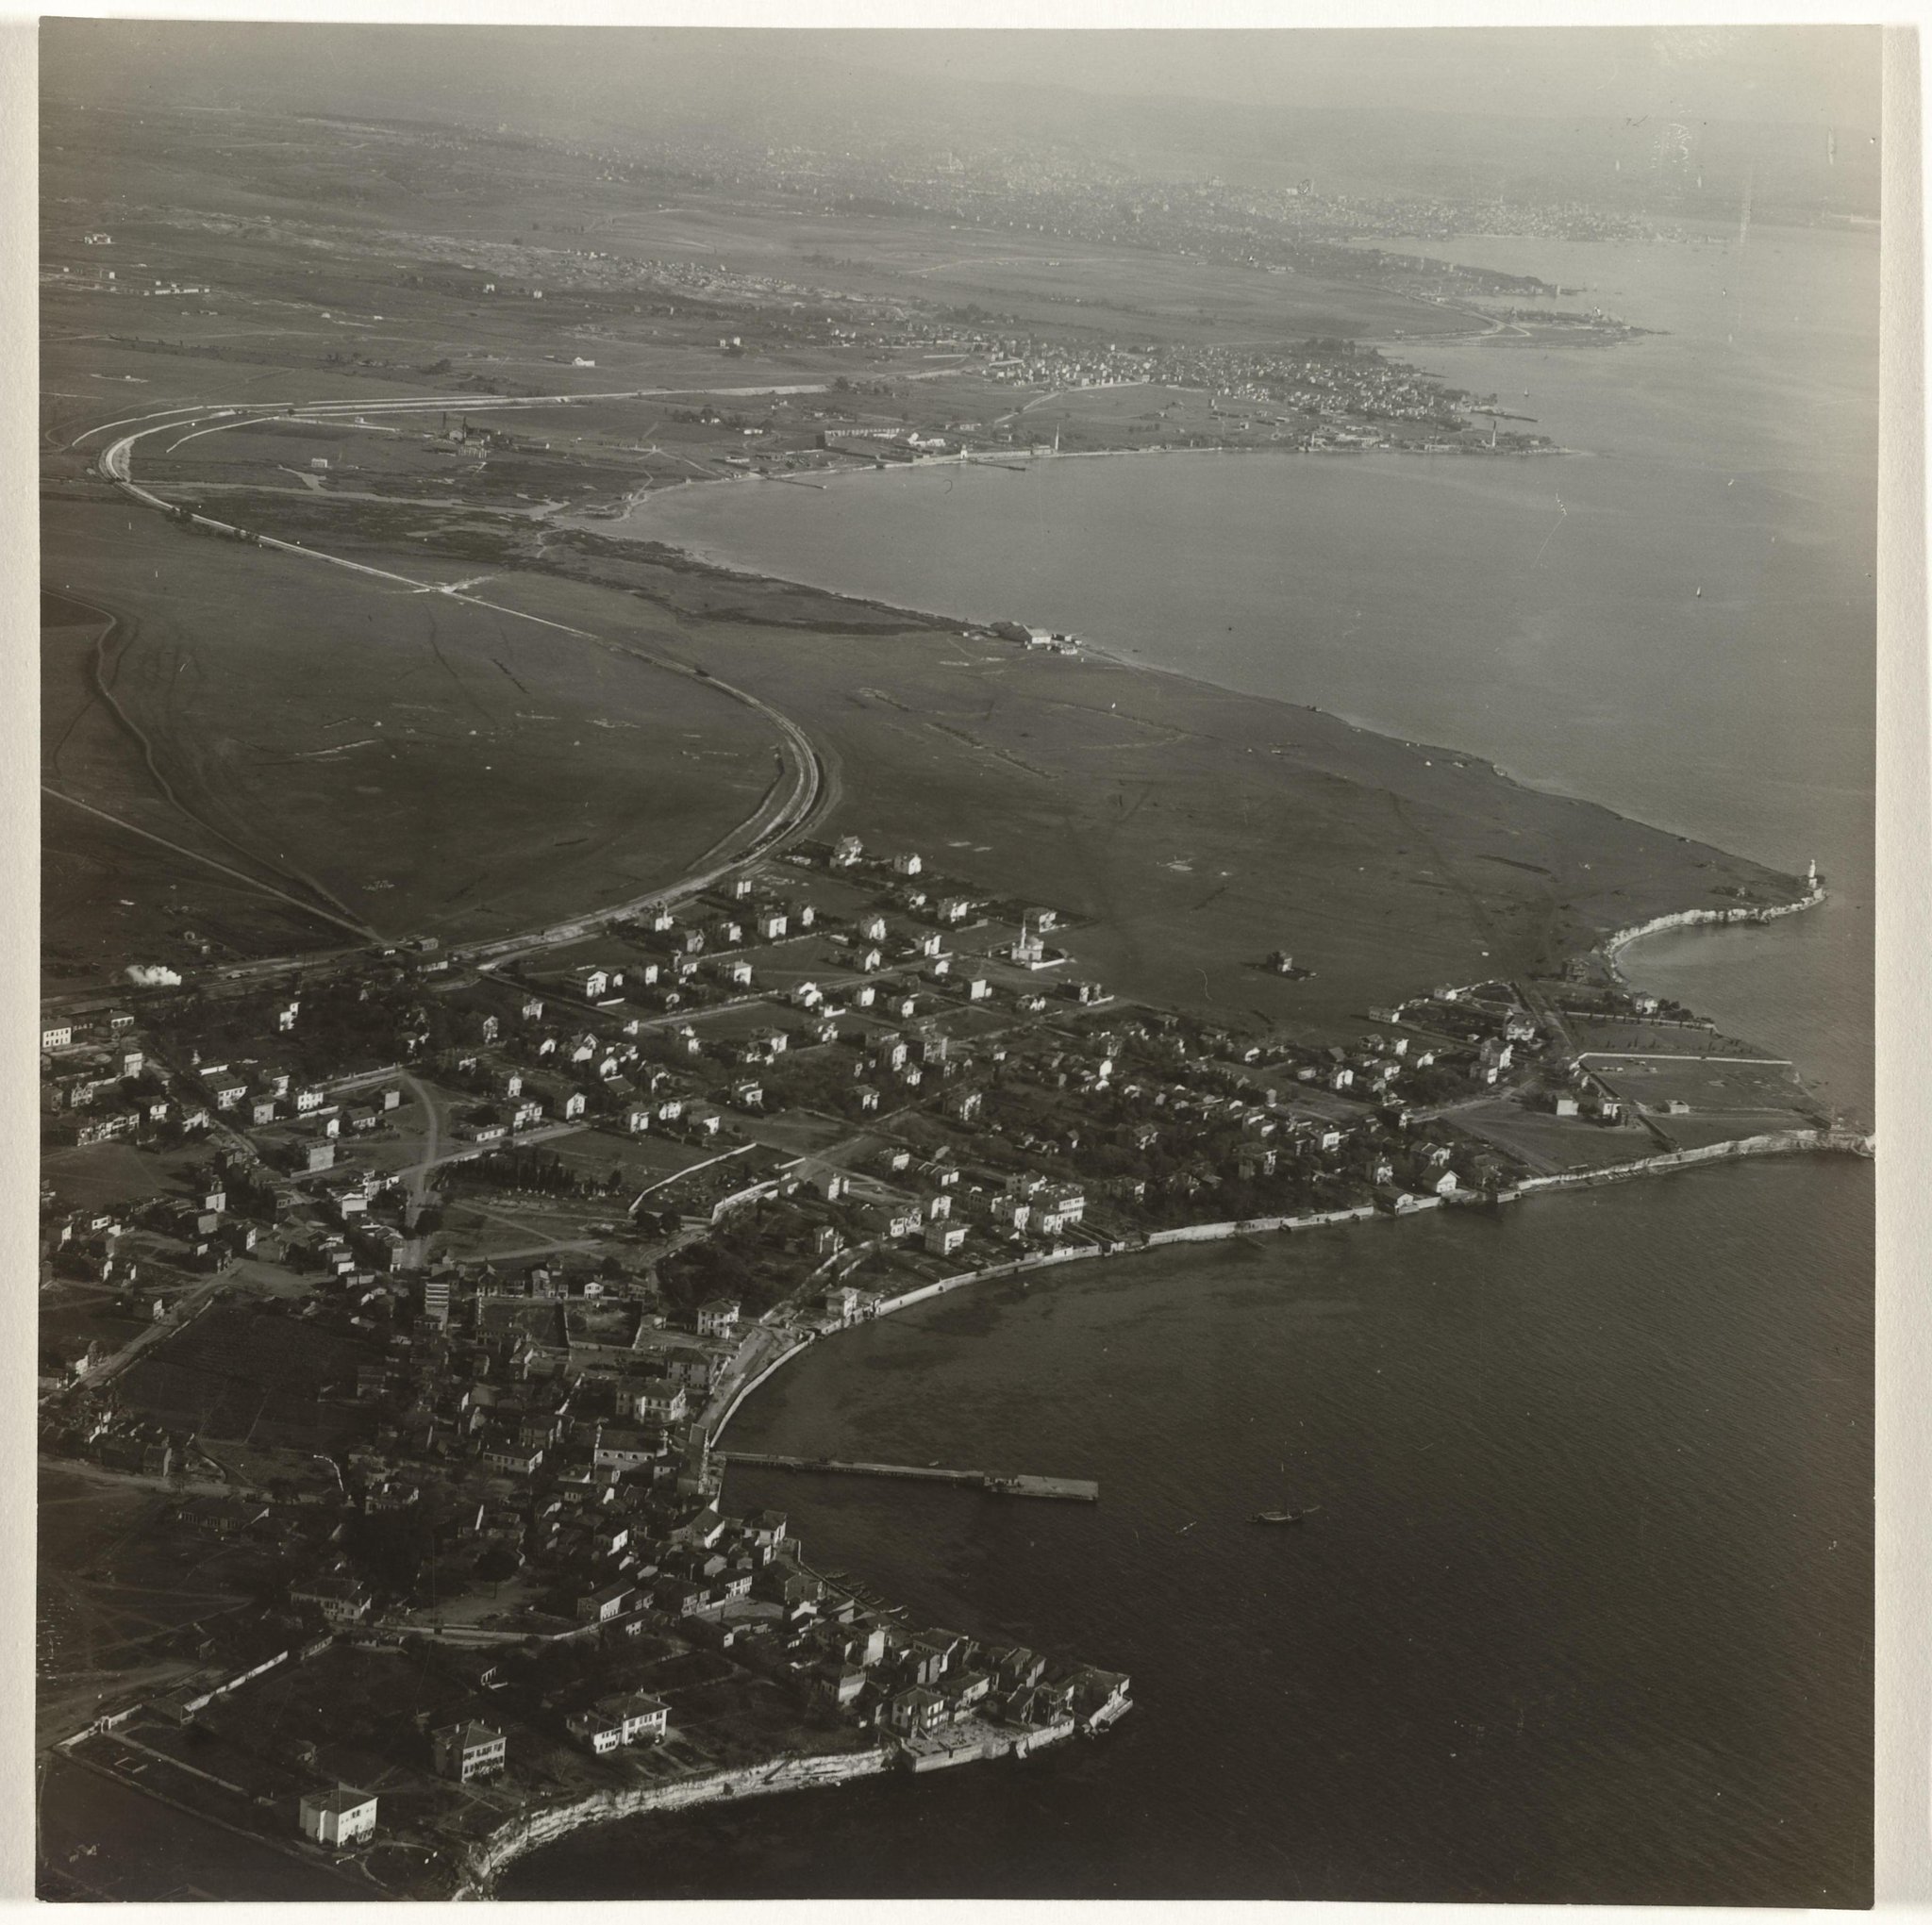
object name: photograph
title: Luchtfoto in zwart-wit van een stad of dorp, gelegen aan het water, met weilanden op de achtergrond, gelegen aan een baai met een kade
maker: Anonymous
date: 1930-1975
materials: photographic support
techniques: gelatin silver print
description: Luchtfoto in zwart-wit van een stad of dorp, gelegen aan het water, met weilanden op de achtergrond, gelegen aan een baai met een kade (voor).